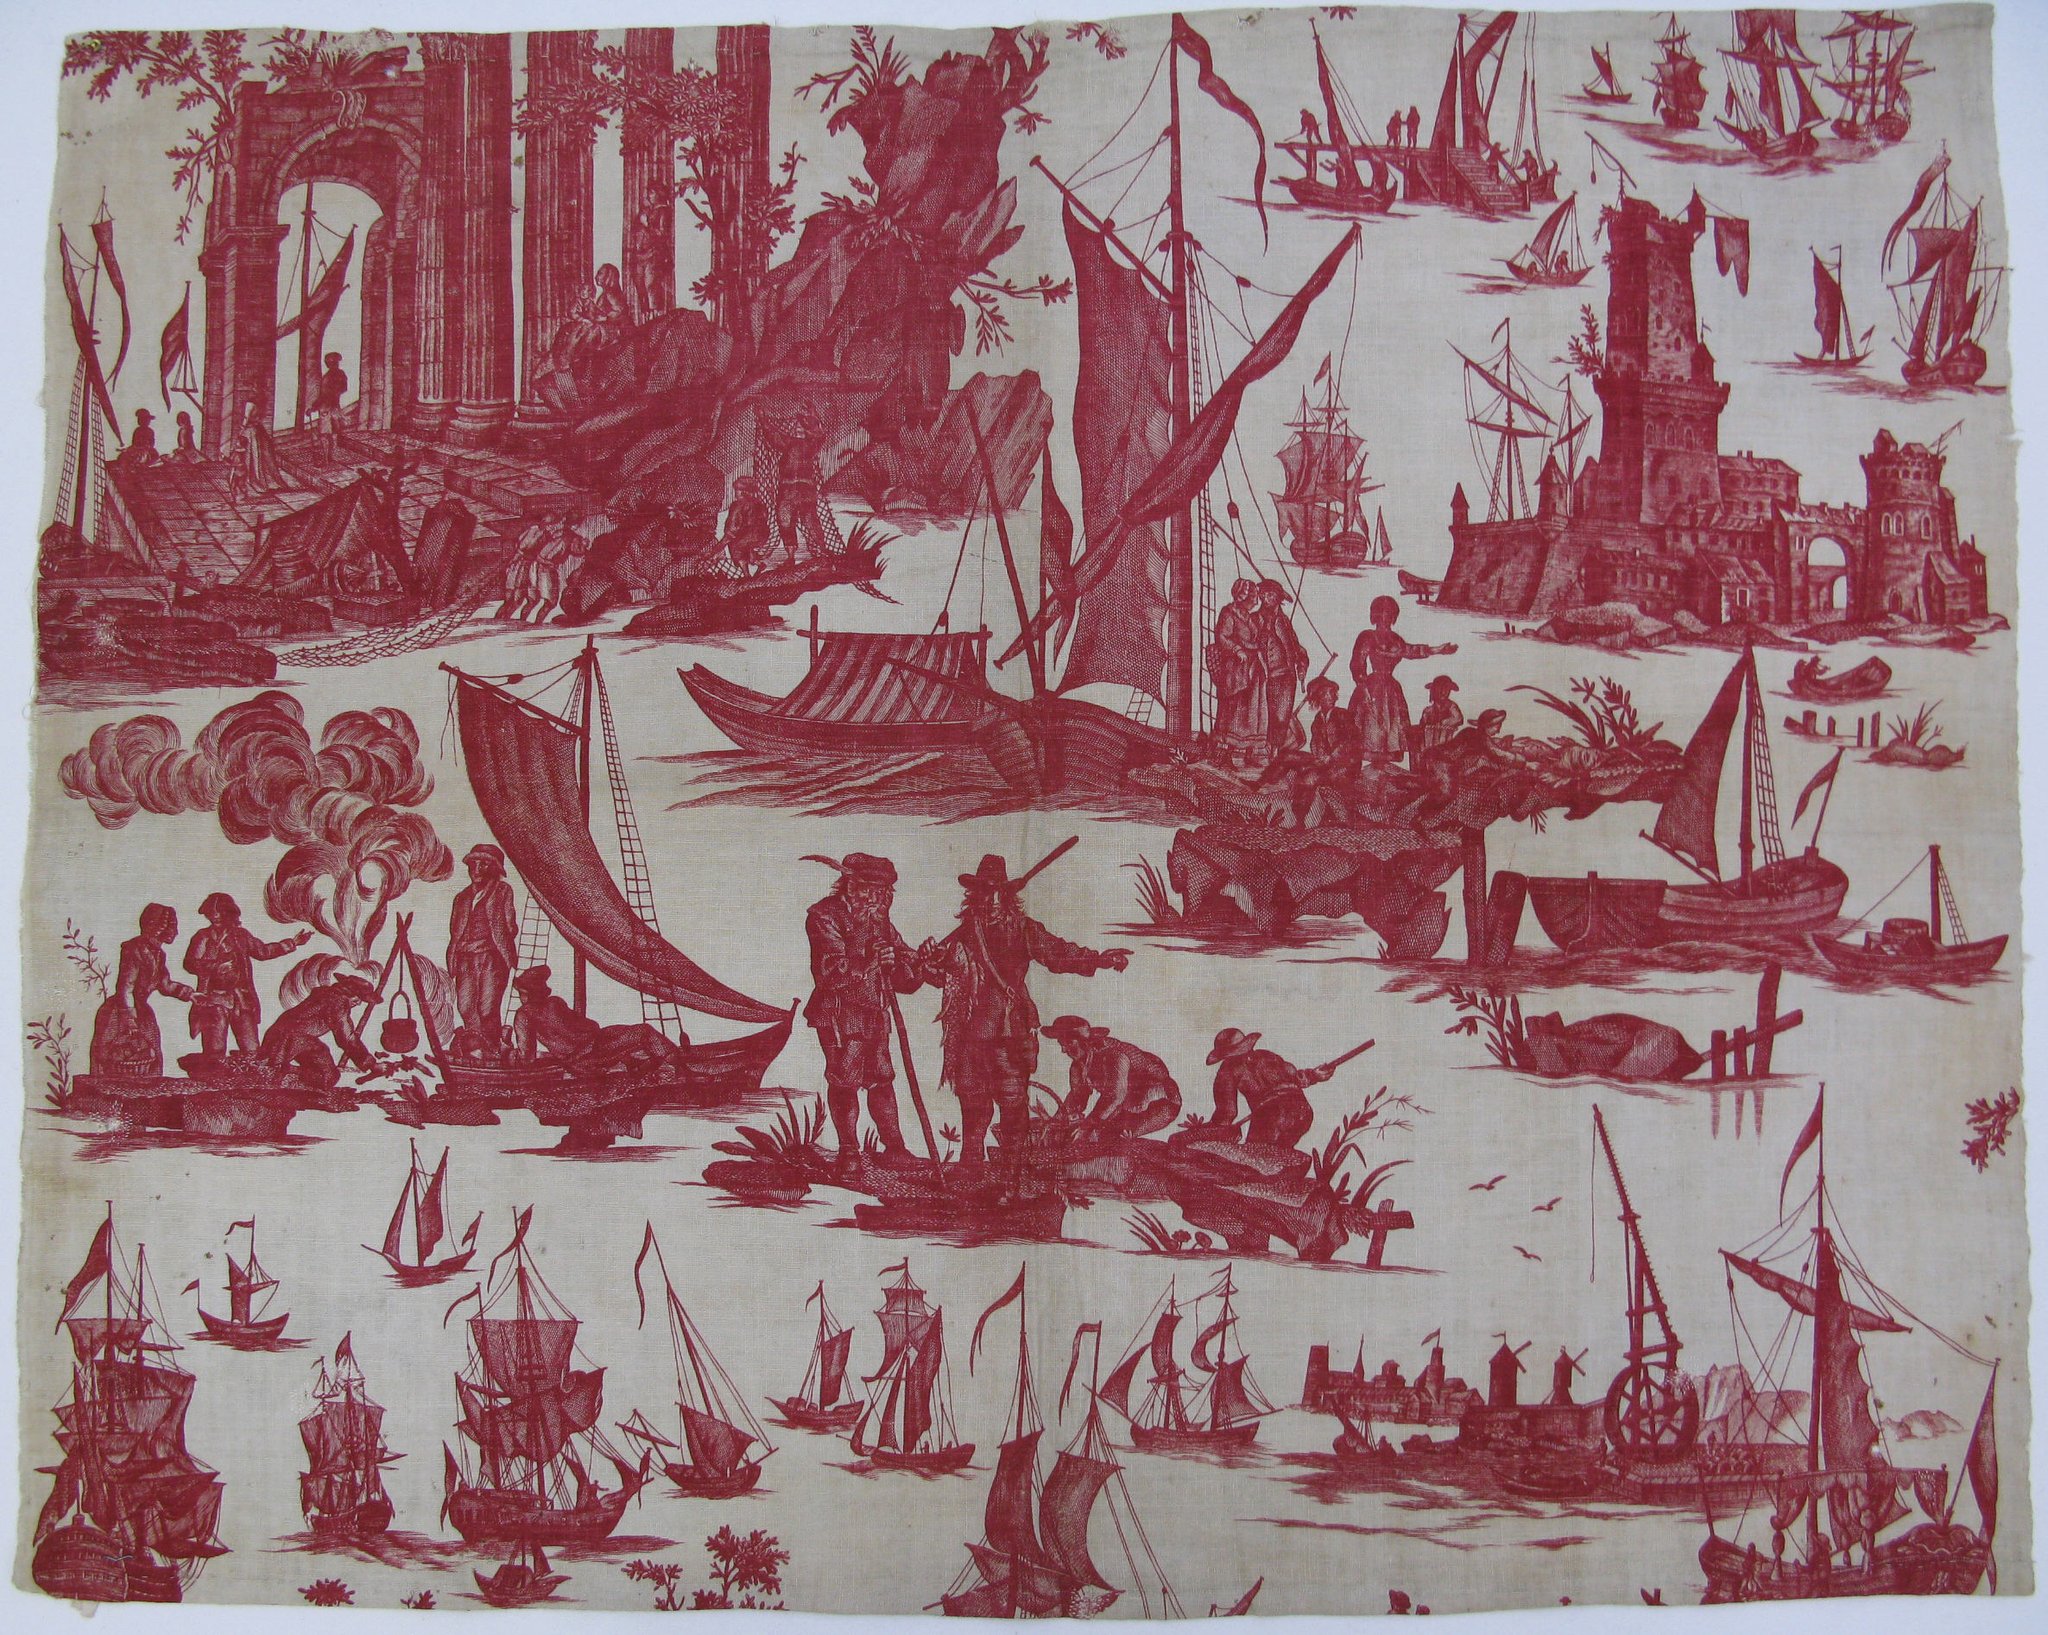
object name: length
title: Maritime scene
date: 1780-1799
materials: cotton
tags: men,women,boats,ships